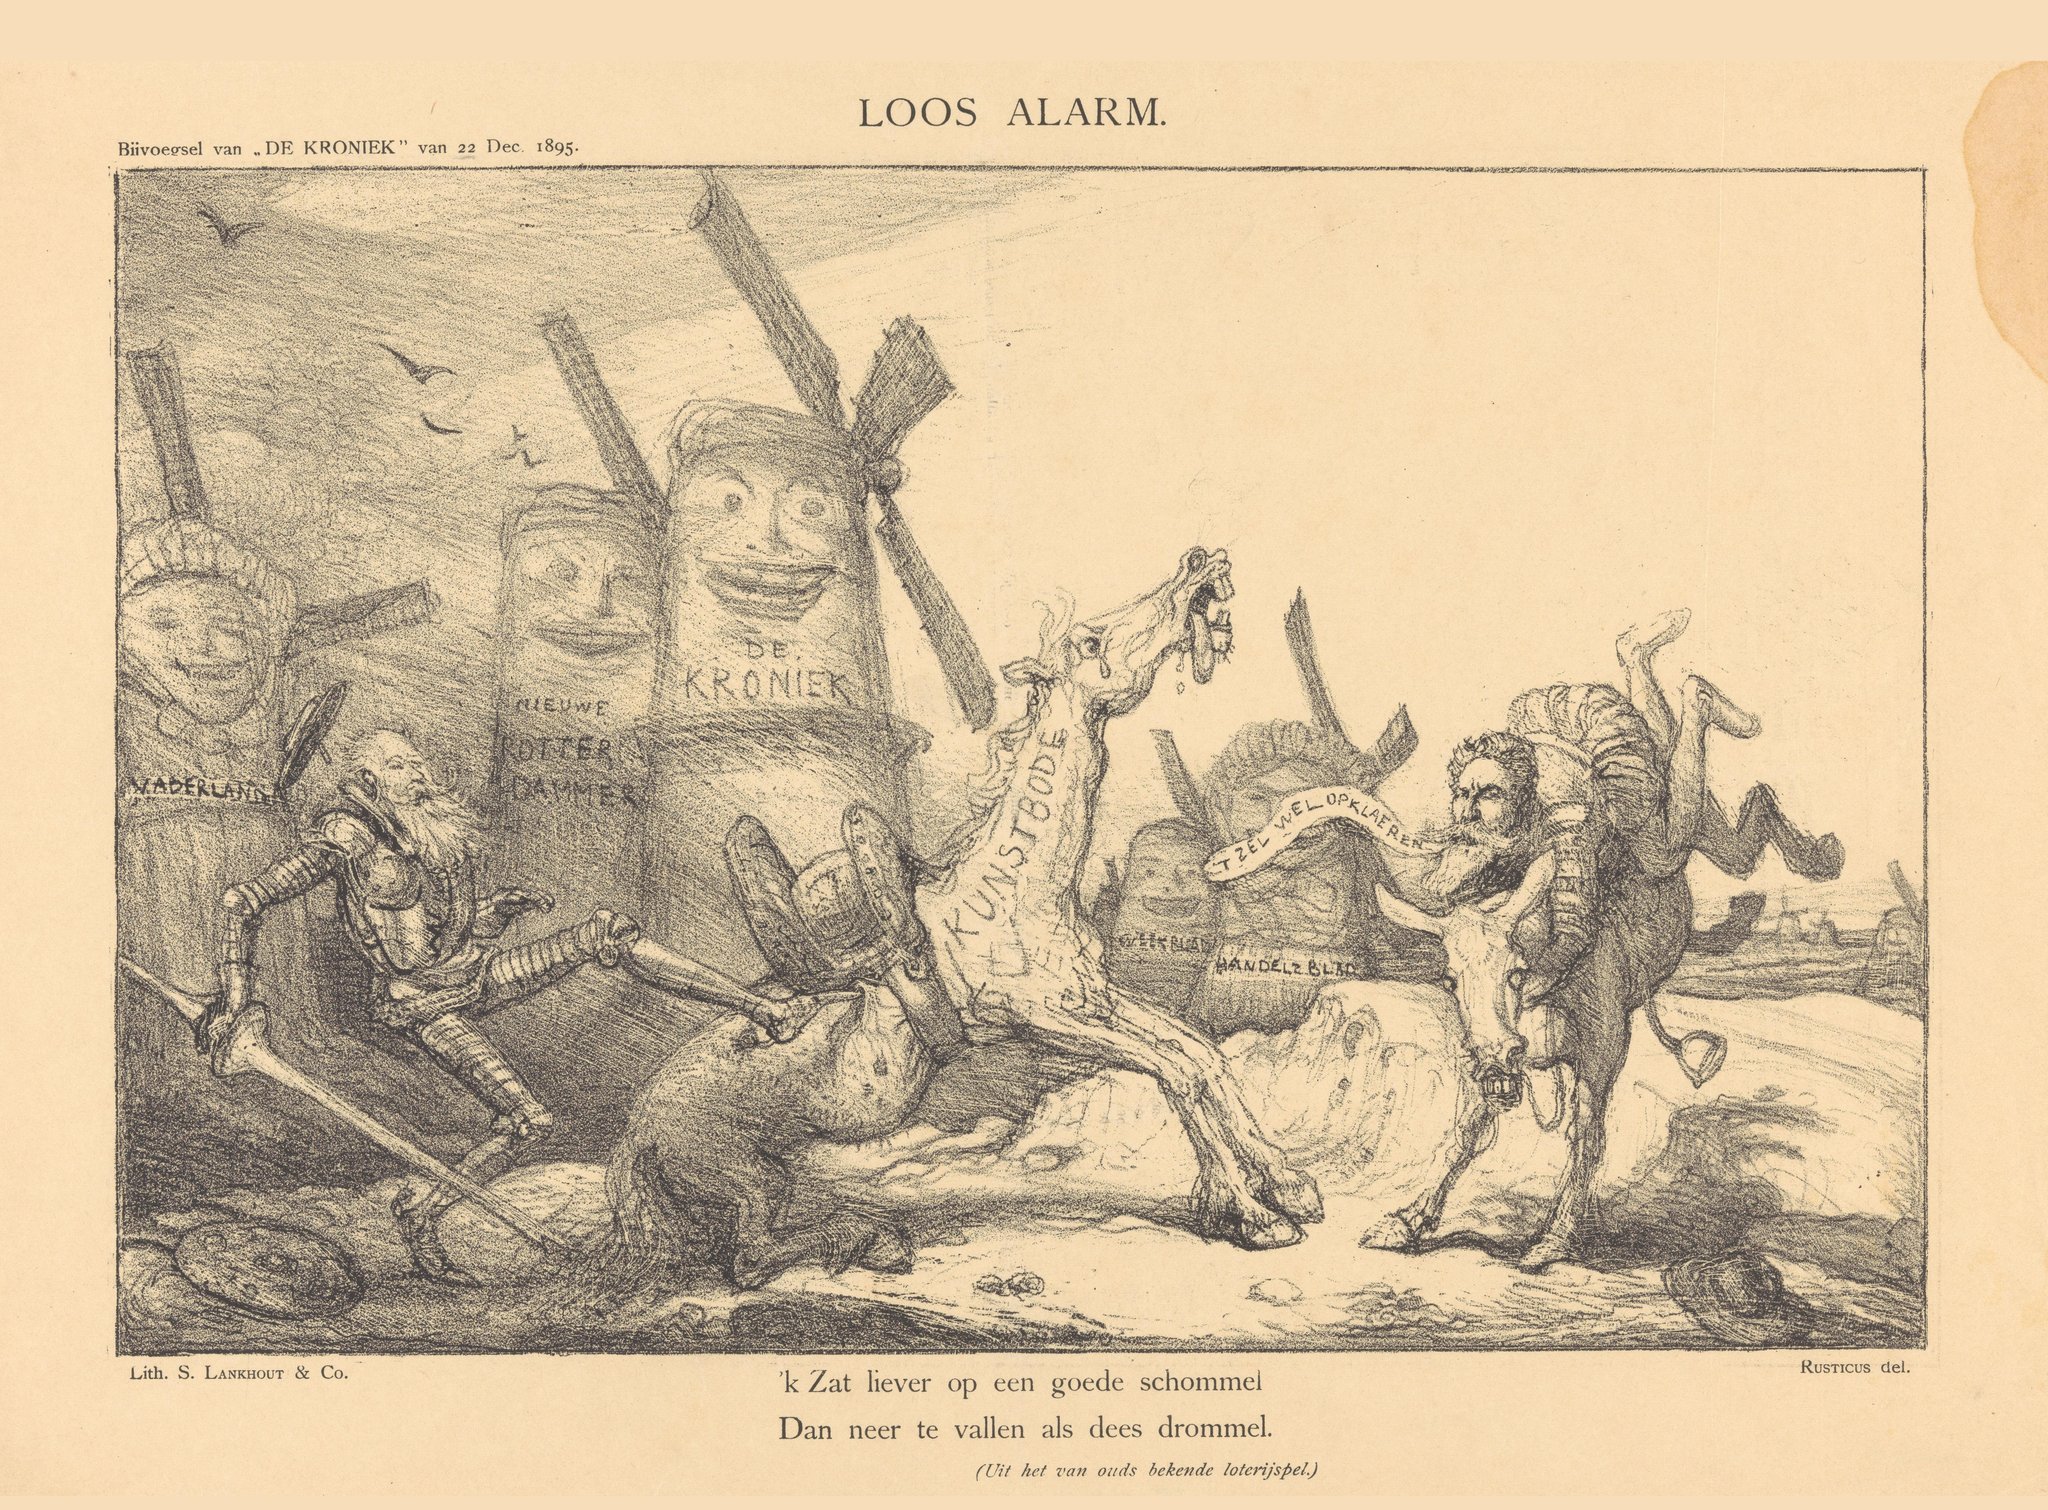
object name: cartoon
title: Loos alarm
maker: marius bauer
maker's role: draughtsman, print maker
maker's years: 1867-1932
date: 1895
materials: paper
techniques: lithograph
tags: painter, print maker, draughtsman, johannes gijsbert vogel, delft, pieter anne haaxman, political caricatures and satires, netherlands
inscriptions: collector's mark: Lugt 2228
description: Spotprent op de mislukte plannen voor de oprichting van het tijdschrift De Kunstbode, door J.G. Vogel en P.A. Haaxman jr. De Kunstbode als Don Quichotte strijdend tegen de lachende windmolens van Het Vaderland, De Kroniek, De Nieuwe Rotterdammer en het Handelsblad. Onderaan een tweeregelig vers. Verschenen in het bijvoegsel van 'De Kroniek' van 22 december 1895.